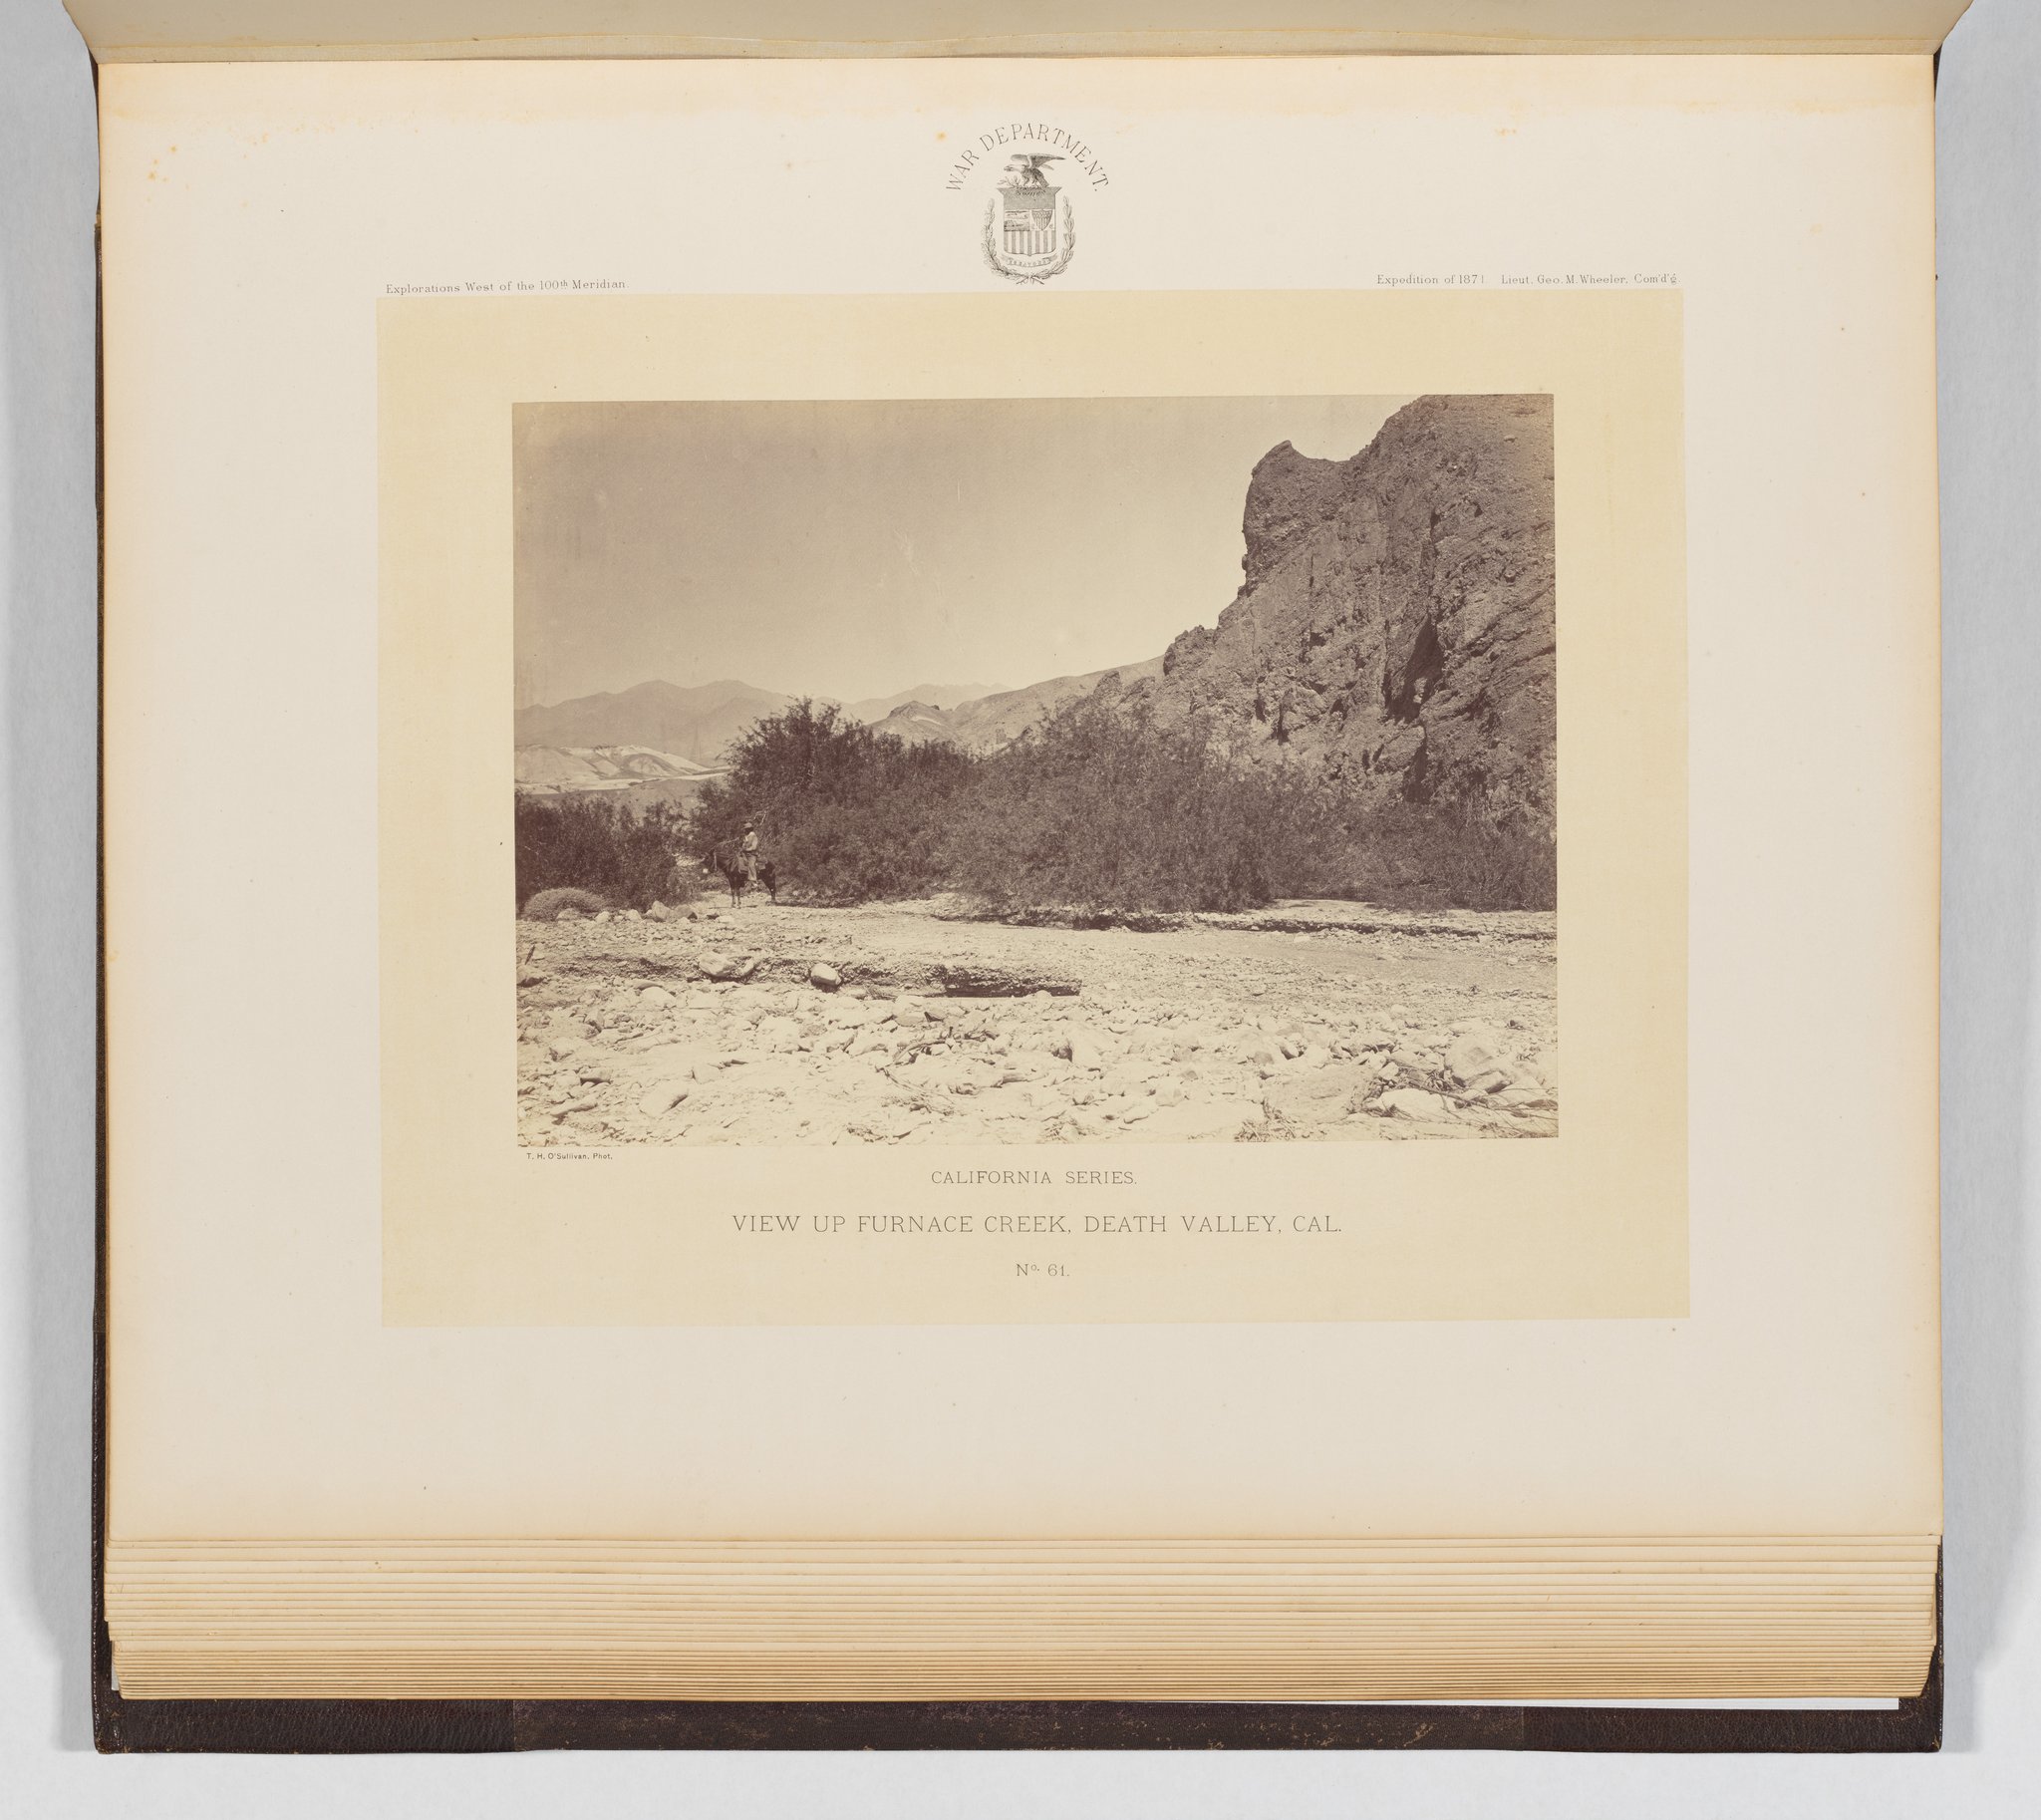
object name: photograph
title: View Up Furnace Creek, Death Valley, California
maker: timothy h. o'sullivan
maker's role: artist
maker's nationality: american, born ireland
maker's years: 1840-1882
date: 1871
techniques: albumen silver print, glass negative